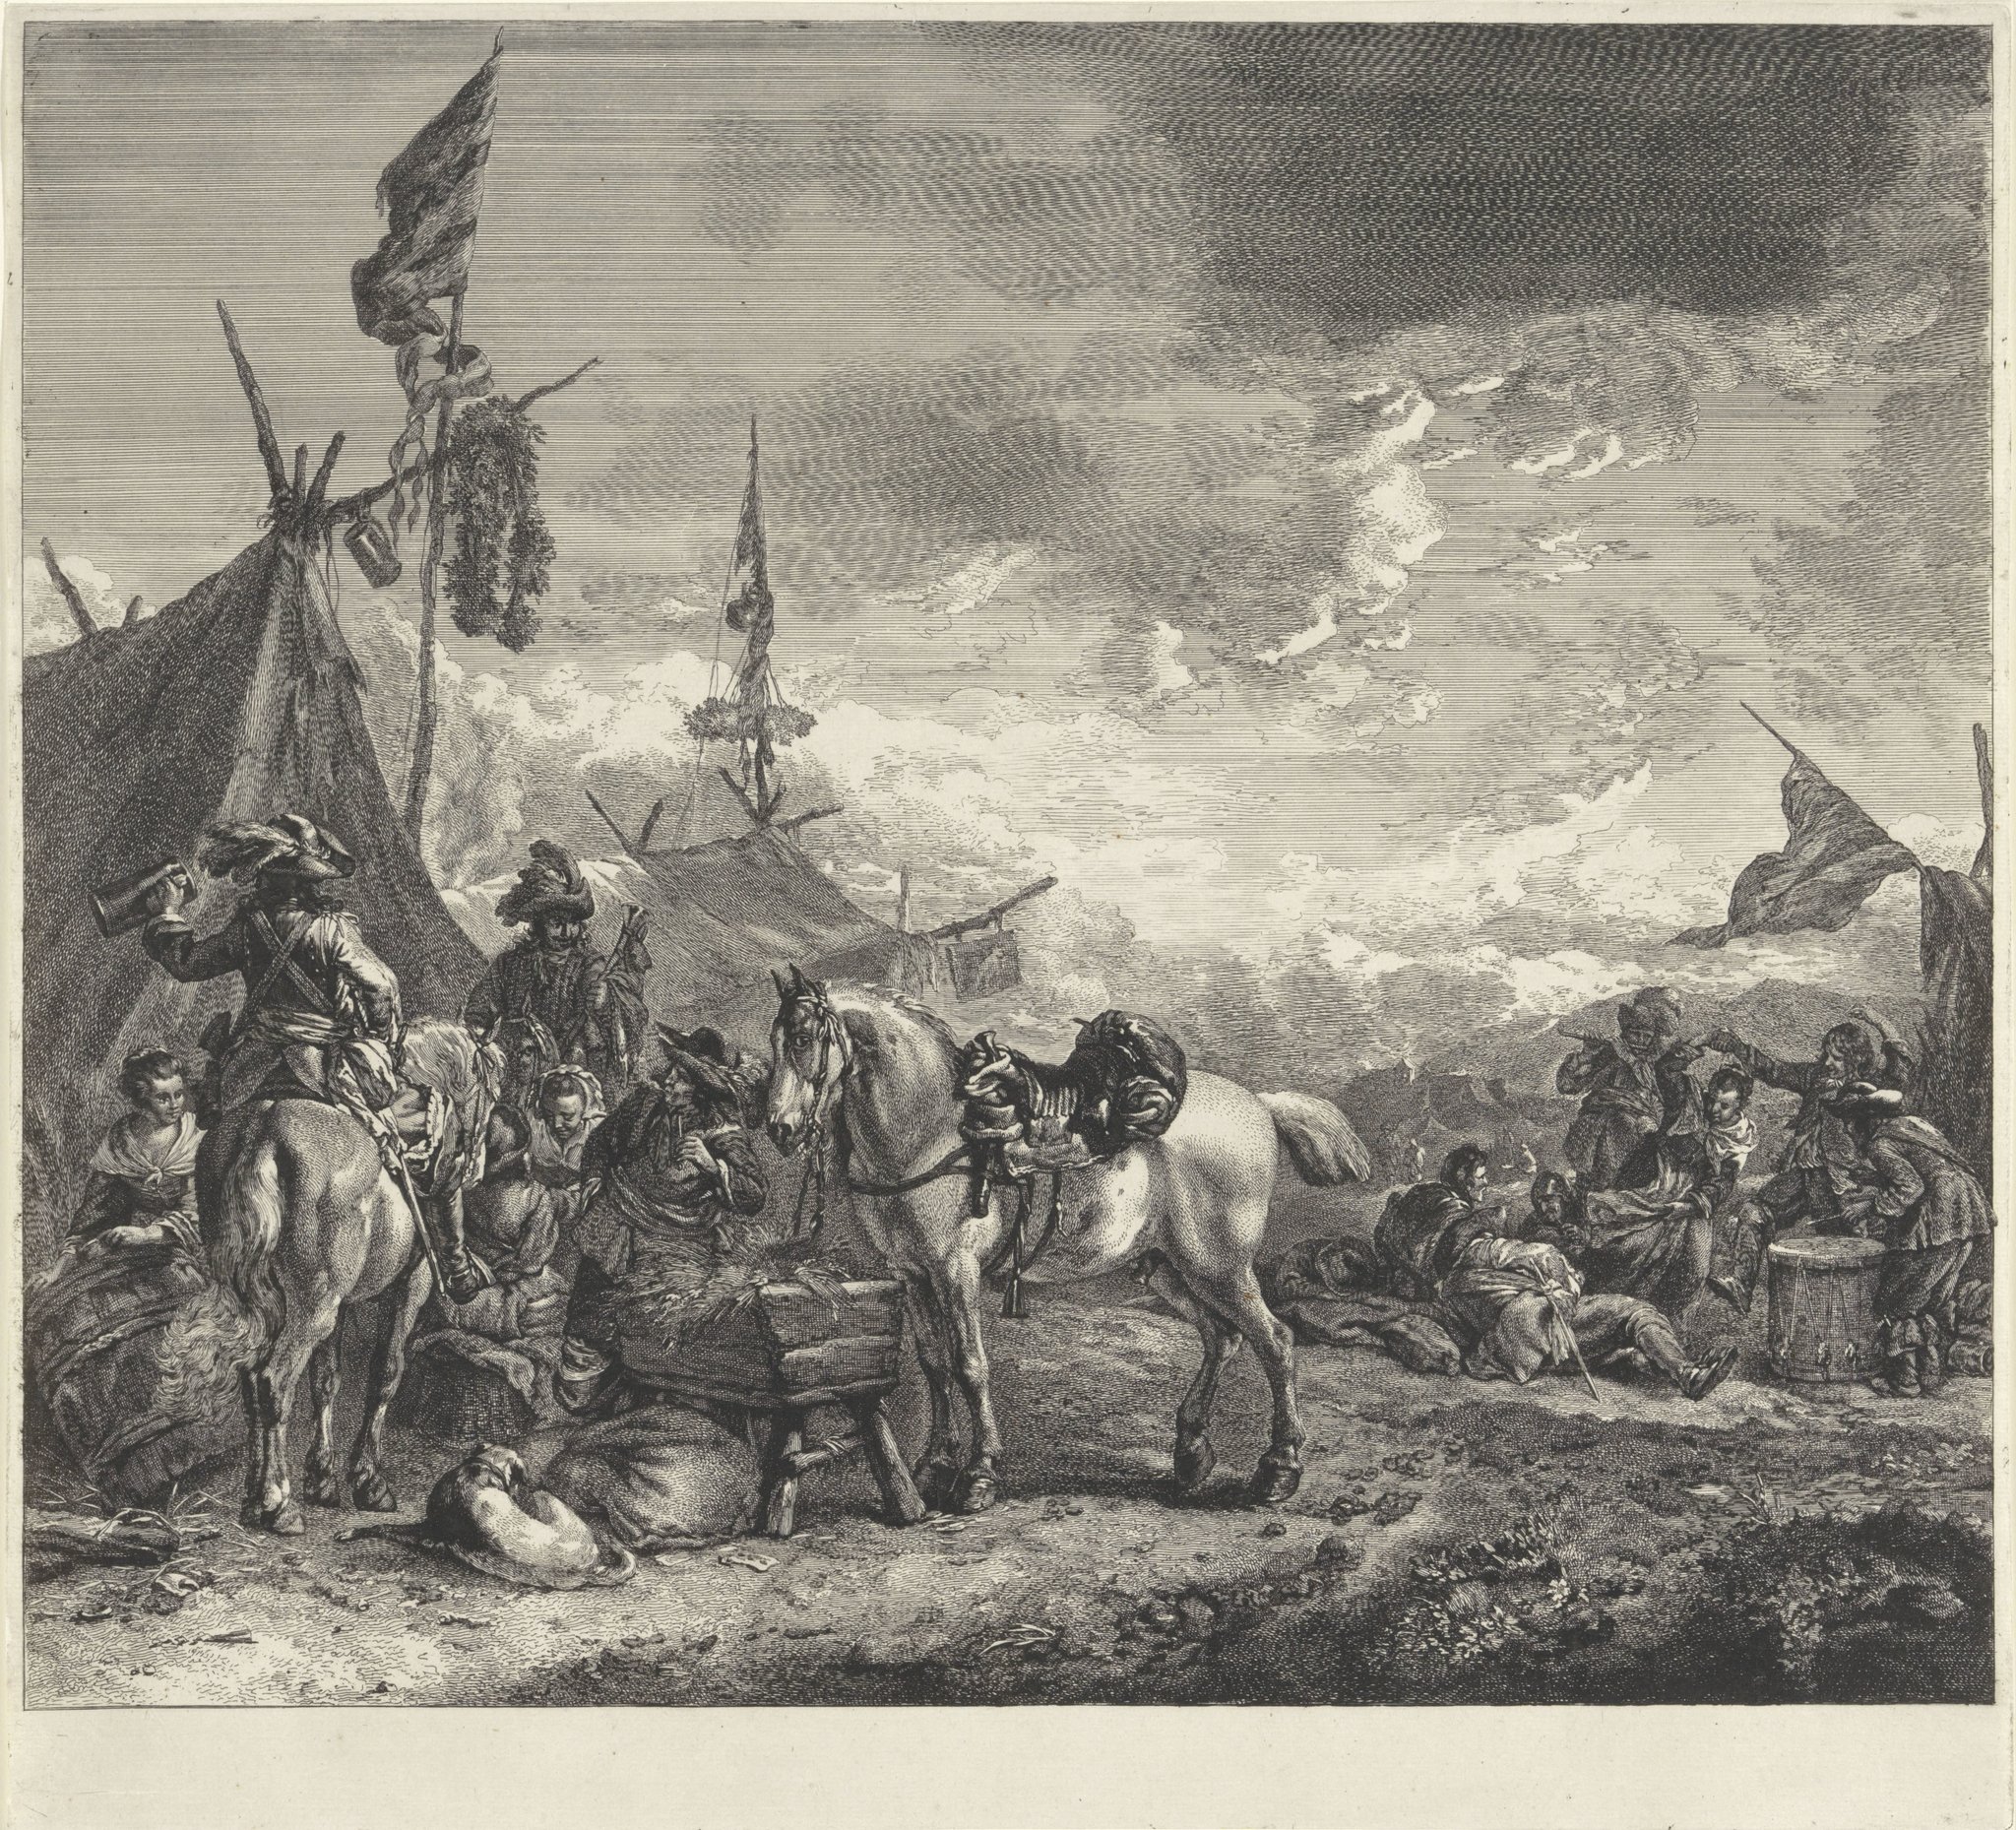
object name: print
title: Soldaten in een tentenkamp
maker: jan de visscher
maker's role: print maker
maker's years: 1633-1712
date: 1643-1692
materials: paper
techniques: engraving, etching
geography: northern netherlands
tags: riding a horse, ass, or mule; rider, horseman, horses and kindred animals, (military) camp with tents, dog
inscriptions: collector's mark: Lugt 240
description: Soldaten, waarvan enkele te paard, vermaken zich bij een tentenkamp met vrouwen, drank, muziek en speelkaarten.